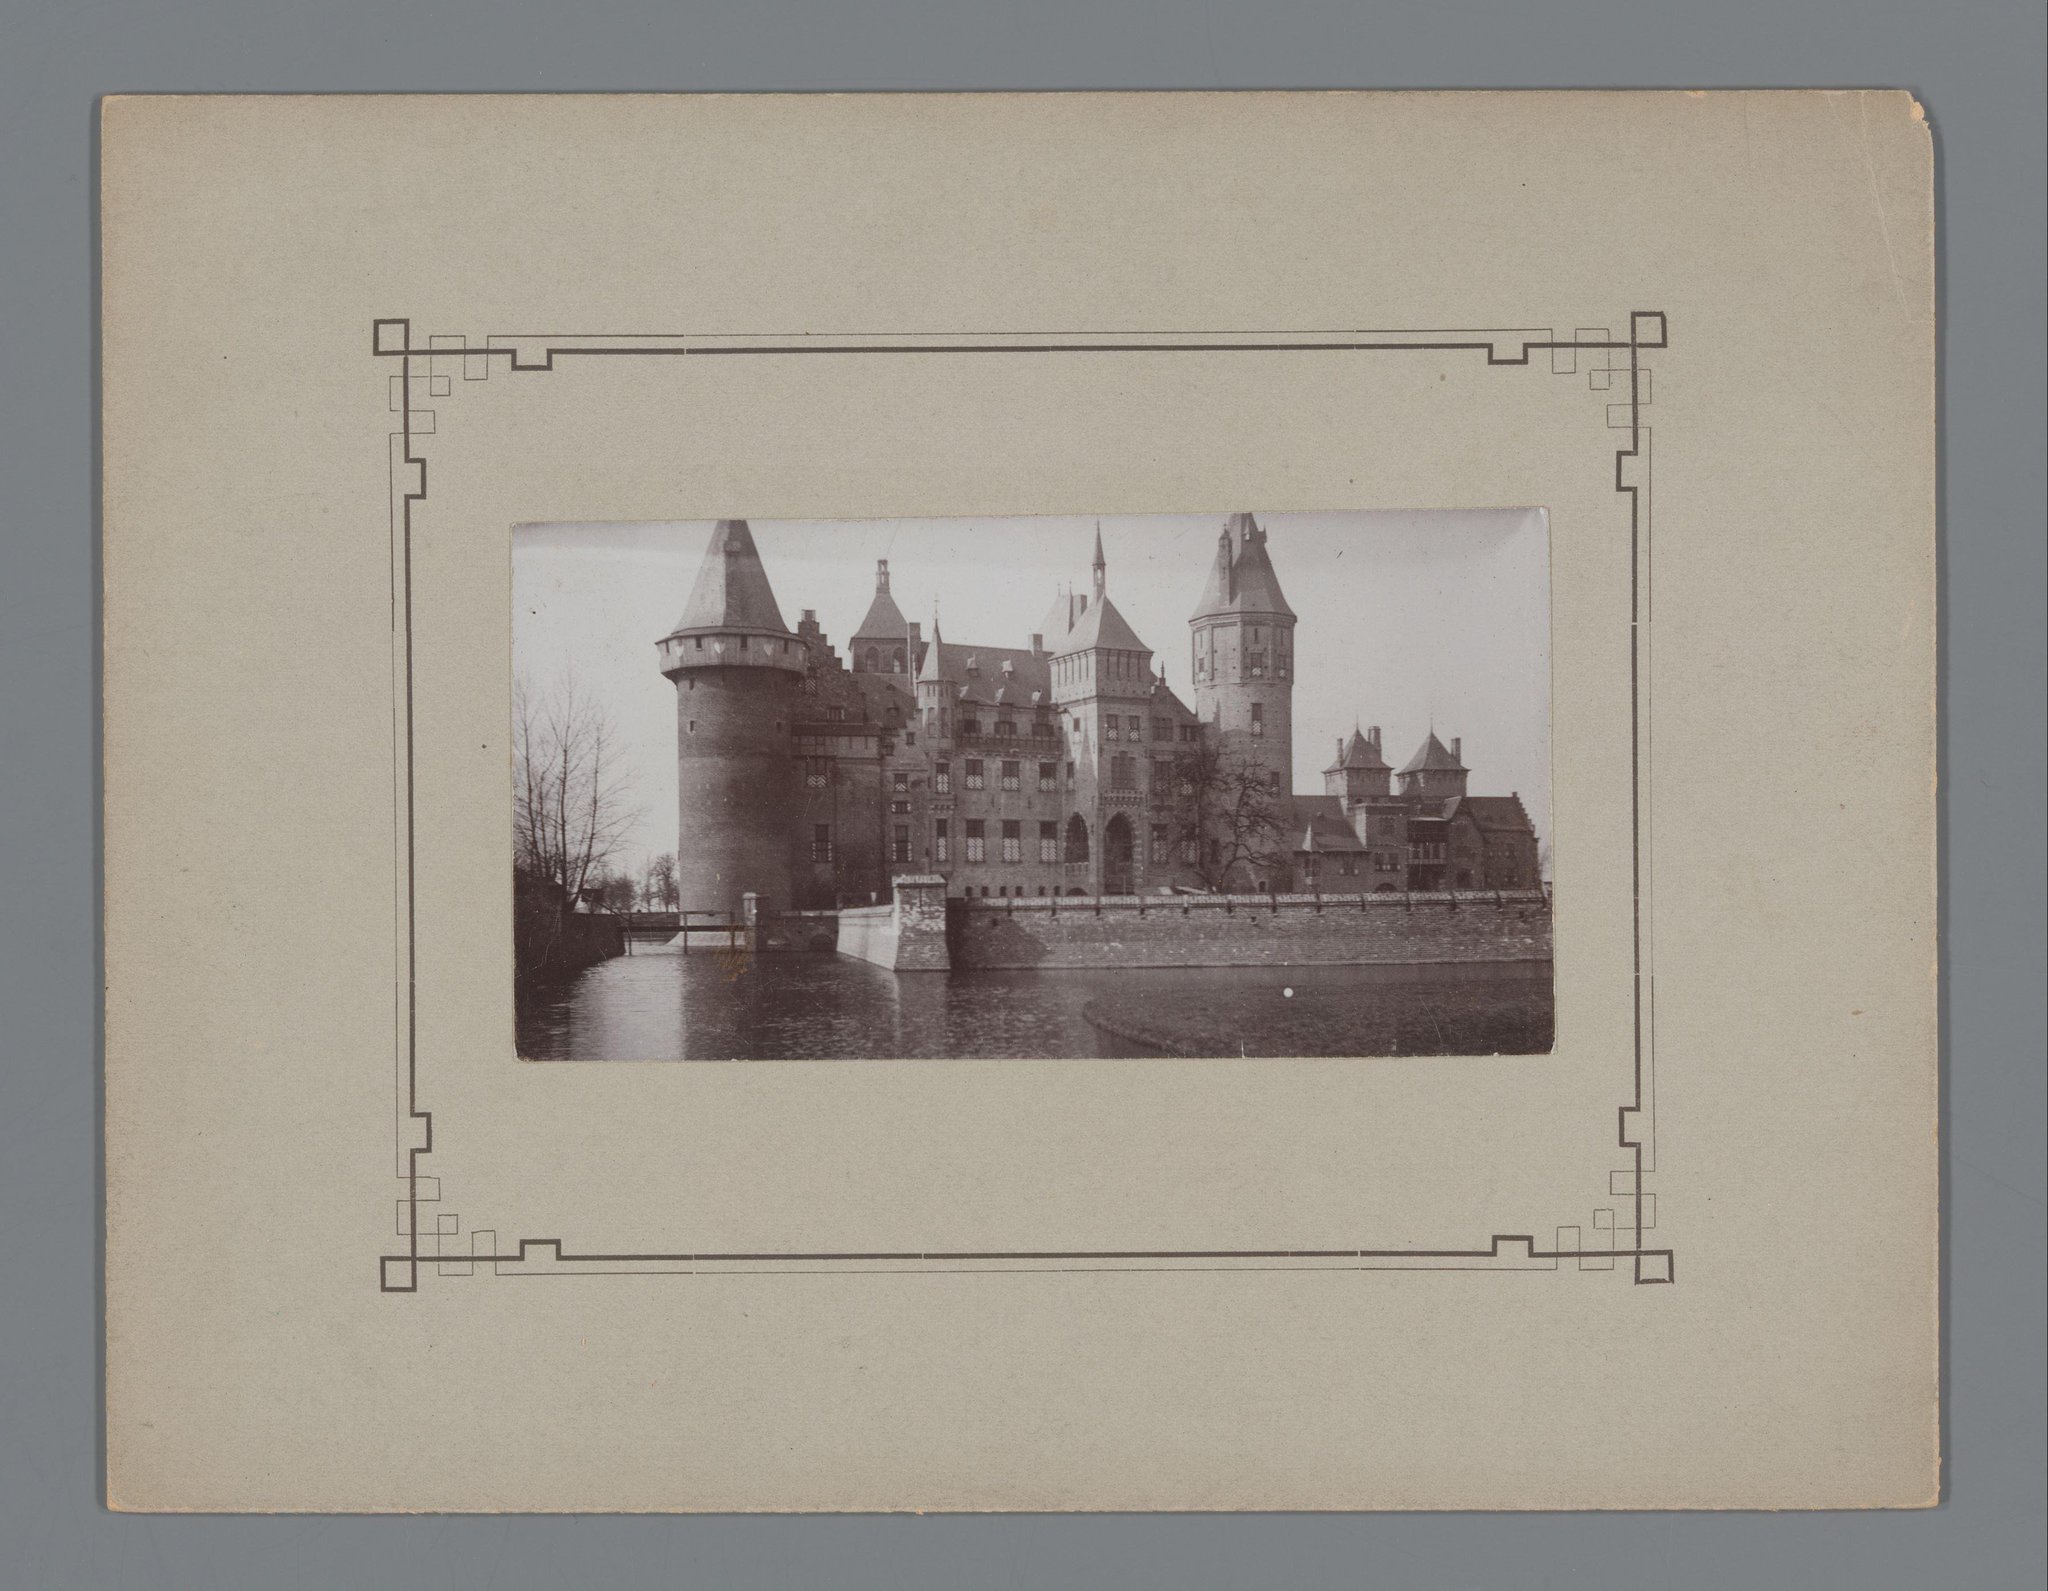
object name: photograph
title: Gezicht op kasteel de Haar te Haarzuilens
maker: Anonymous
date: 1880-1910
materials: cardboard, photographic support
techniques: collodion silver print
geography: haarzuilens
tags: landscape with tower or castle